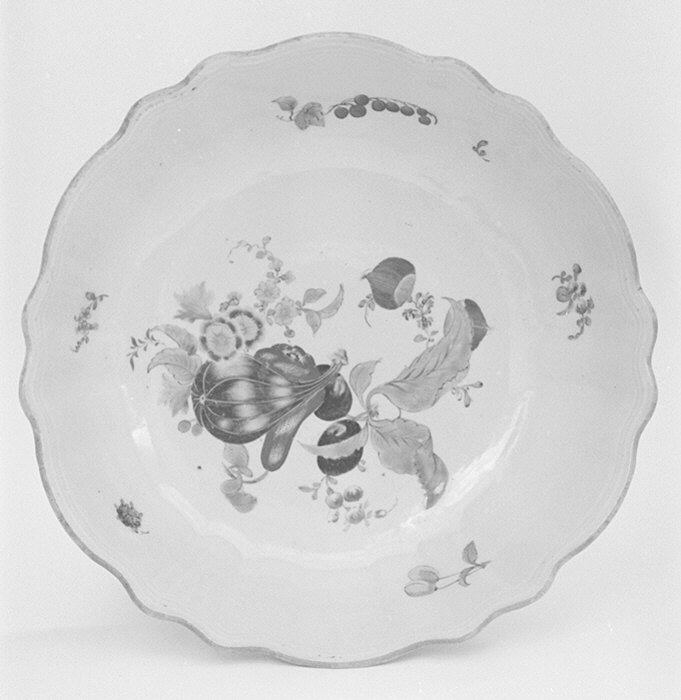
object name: bowl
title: Bowl (part of a service)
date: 1760-1770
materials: hard paste porcelain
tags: fruit,vegetables,flowers